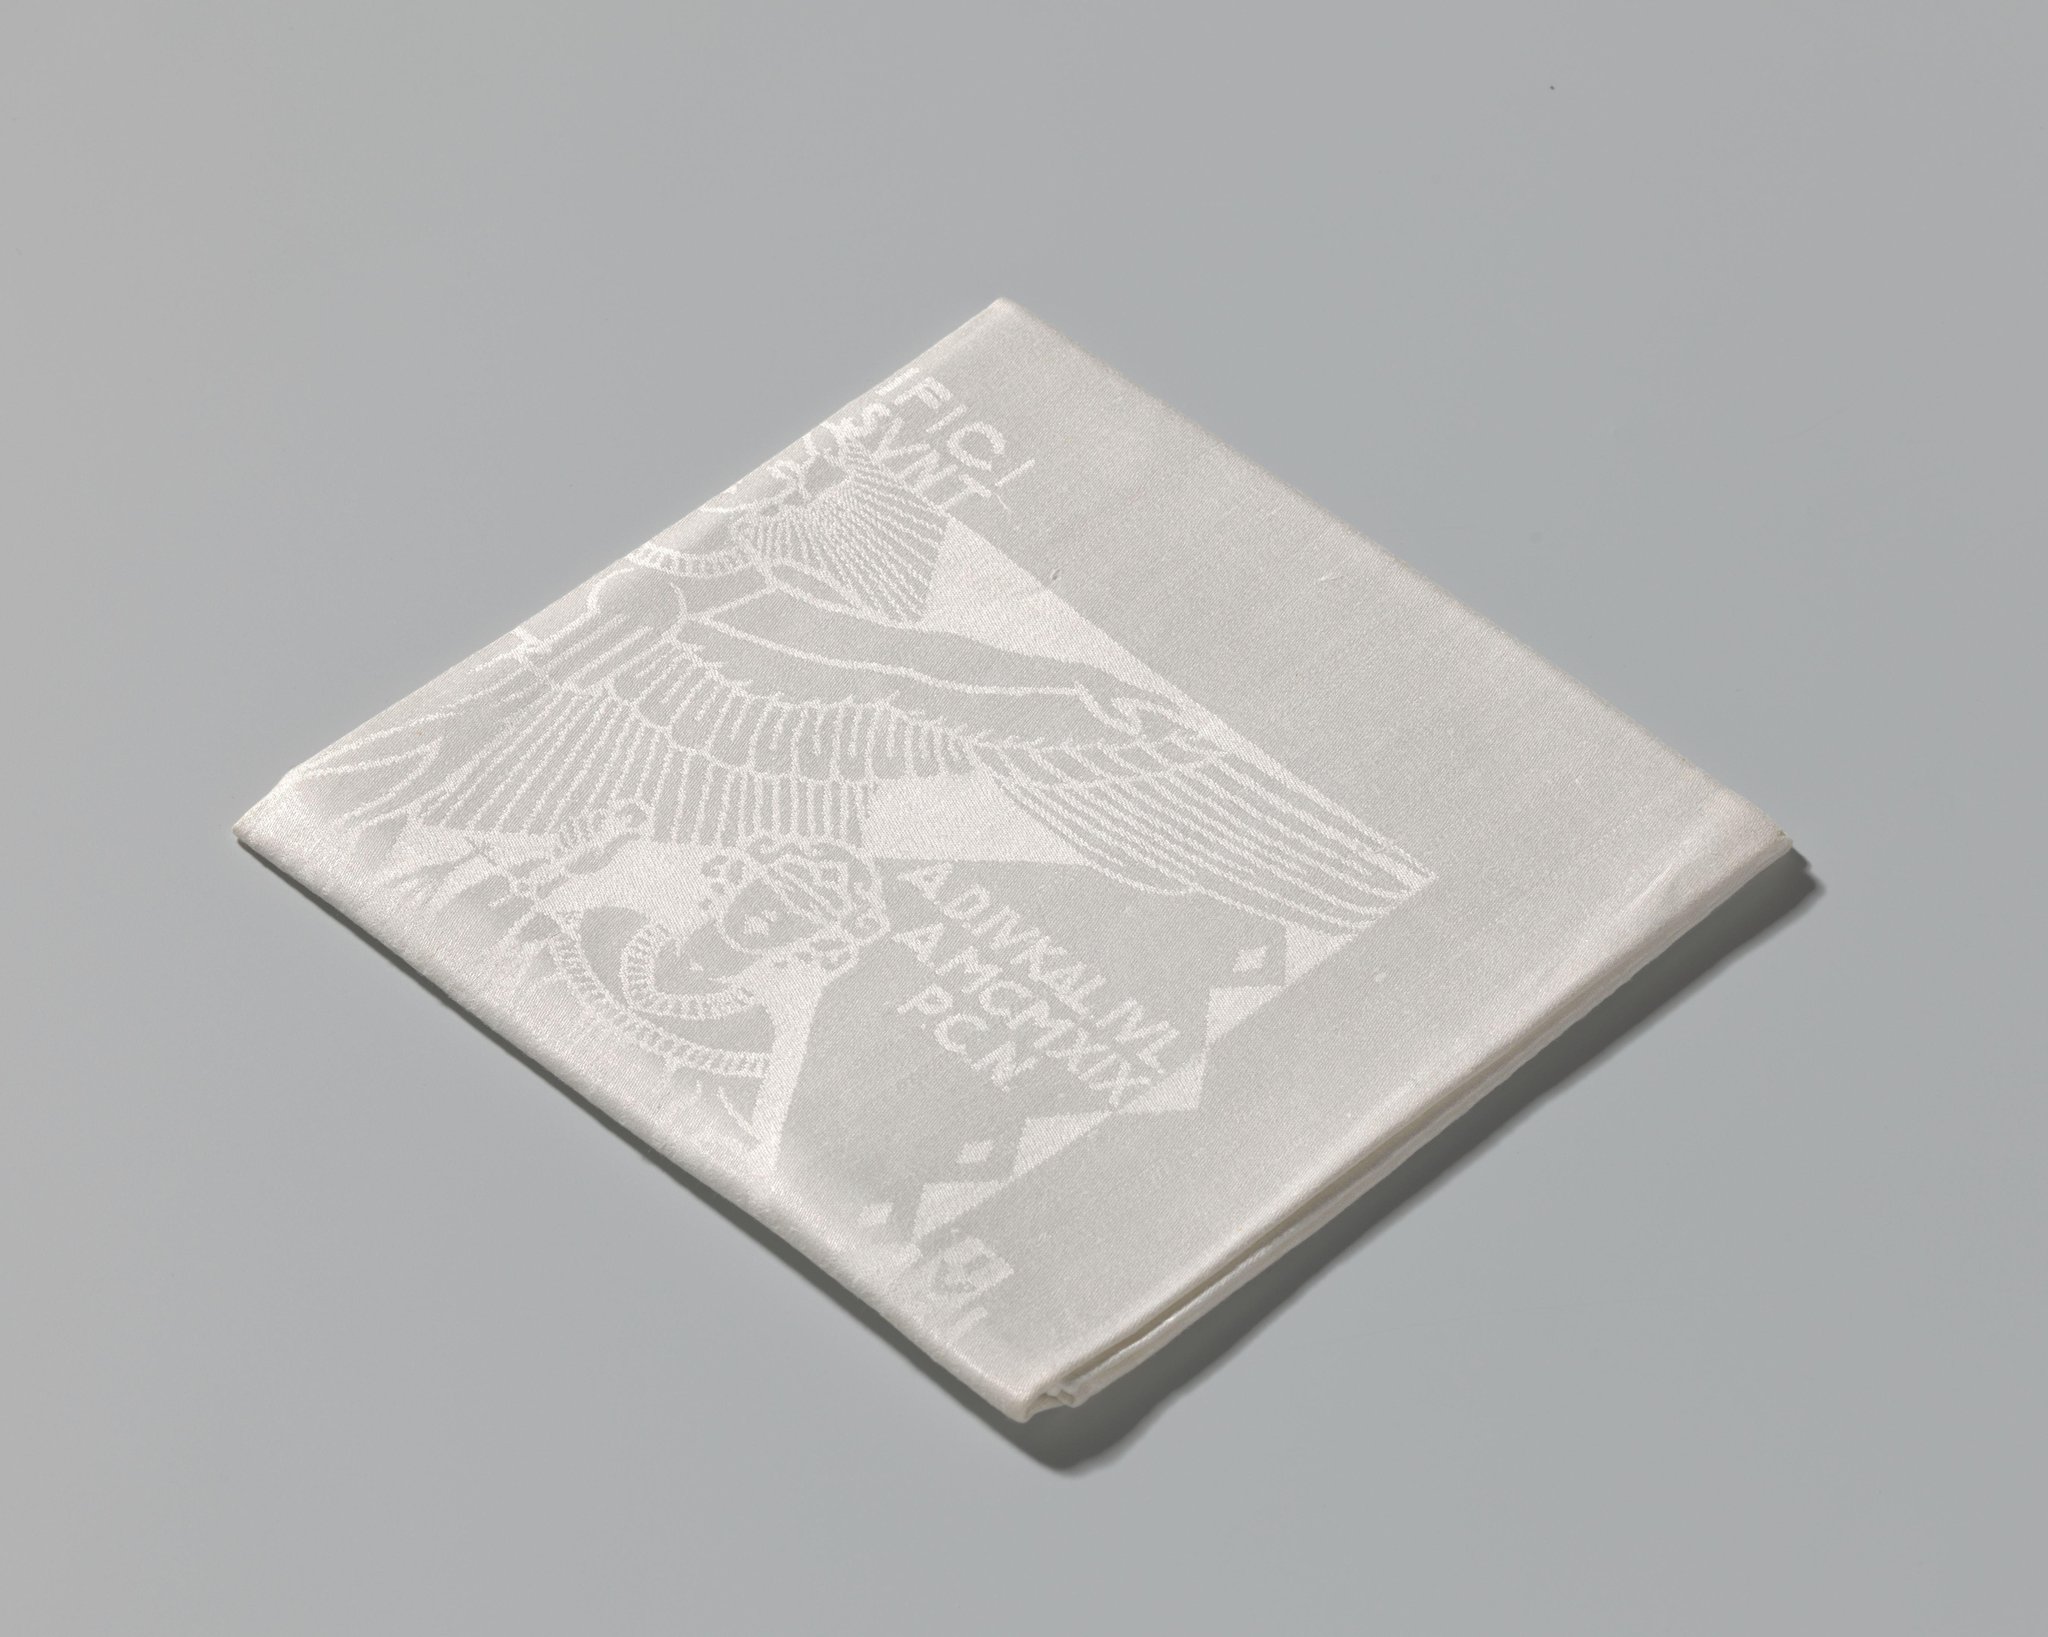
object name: napkin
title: Servet van wit linnendamast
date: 1919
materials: linen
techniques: damask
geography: netherlands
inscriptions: number: ‘558’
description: Wit linnen damasten servet met de Vrede van Versailles.